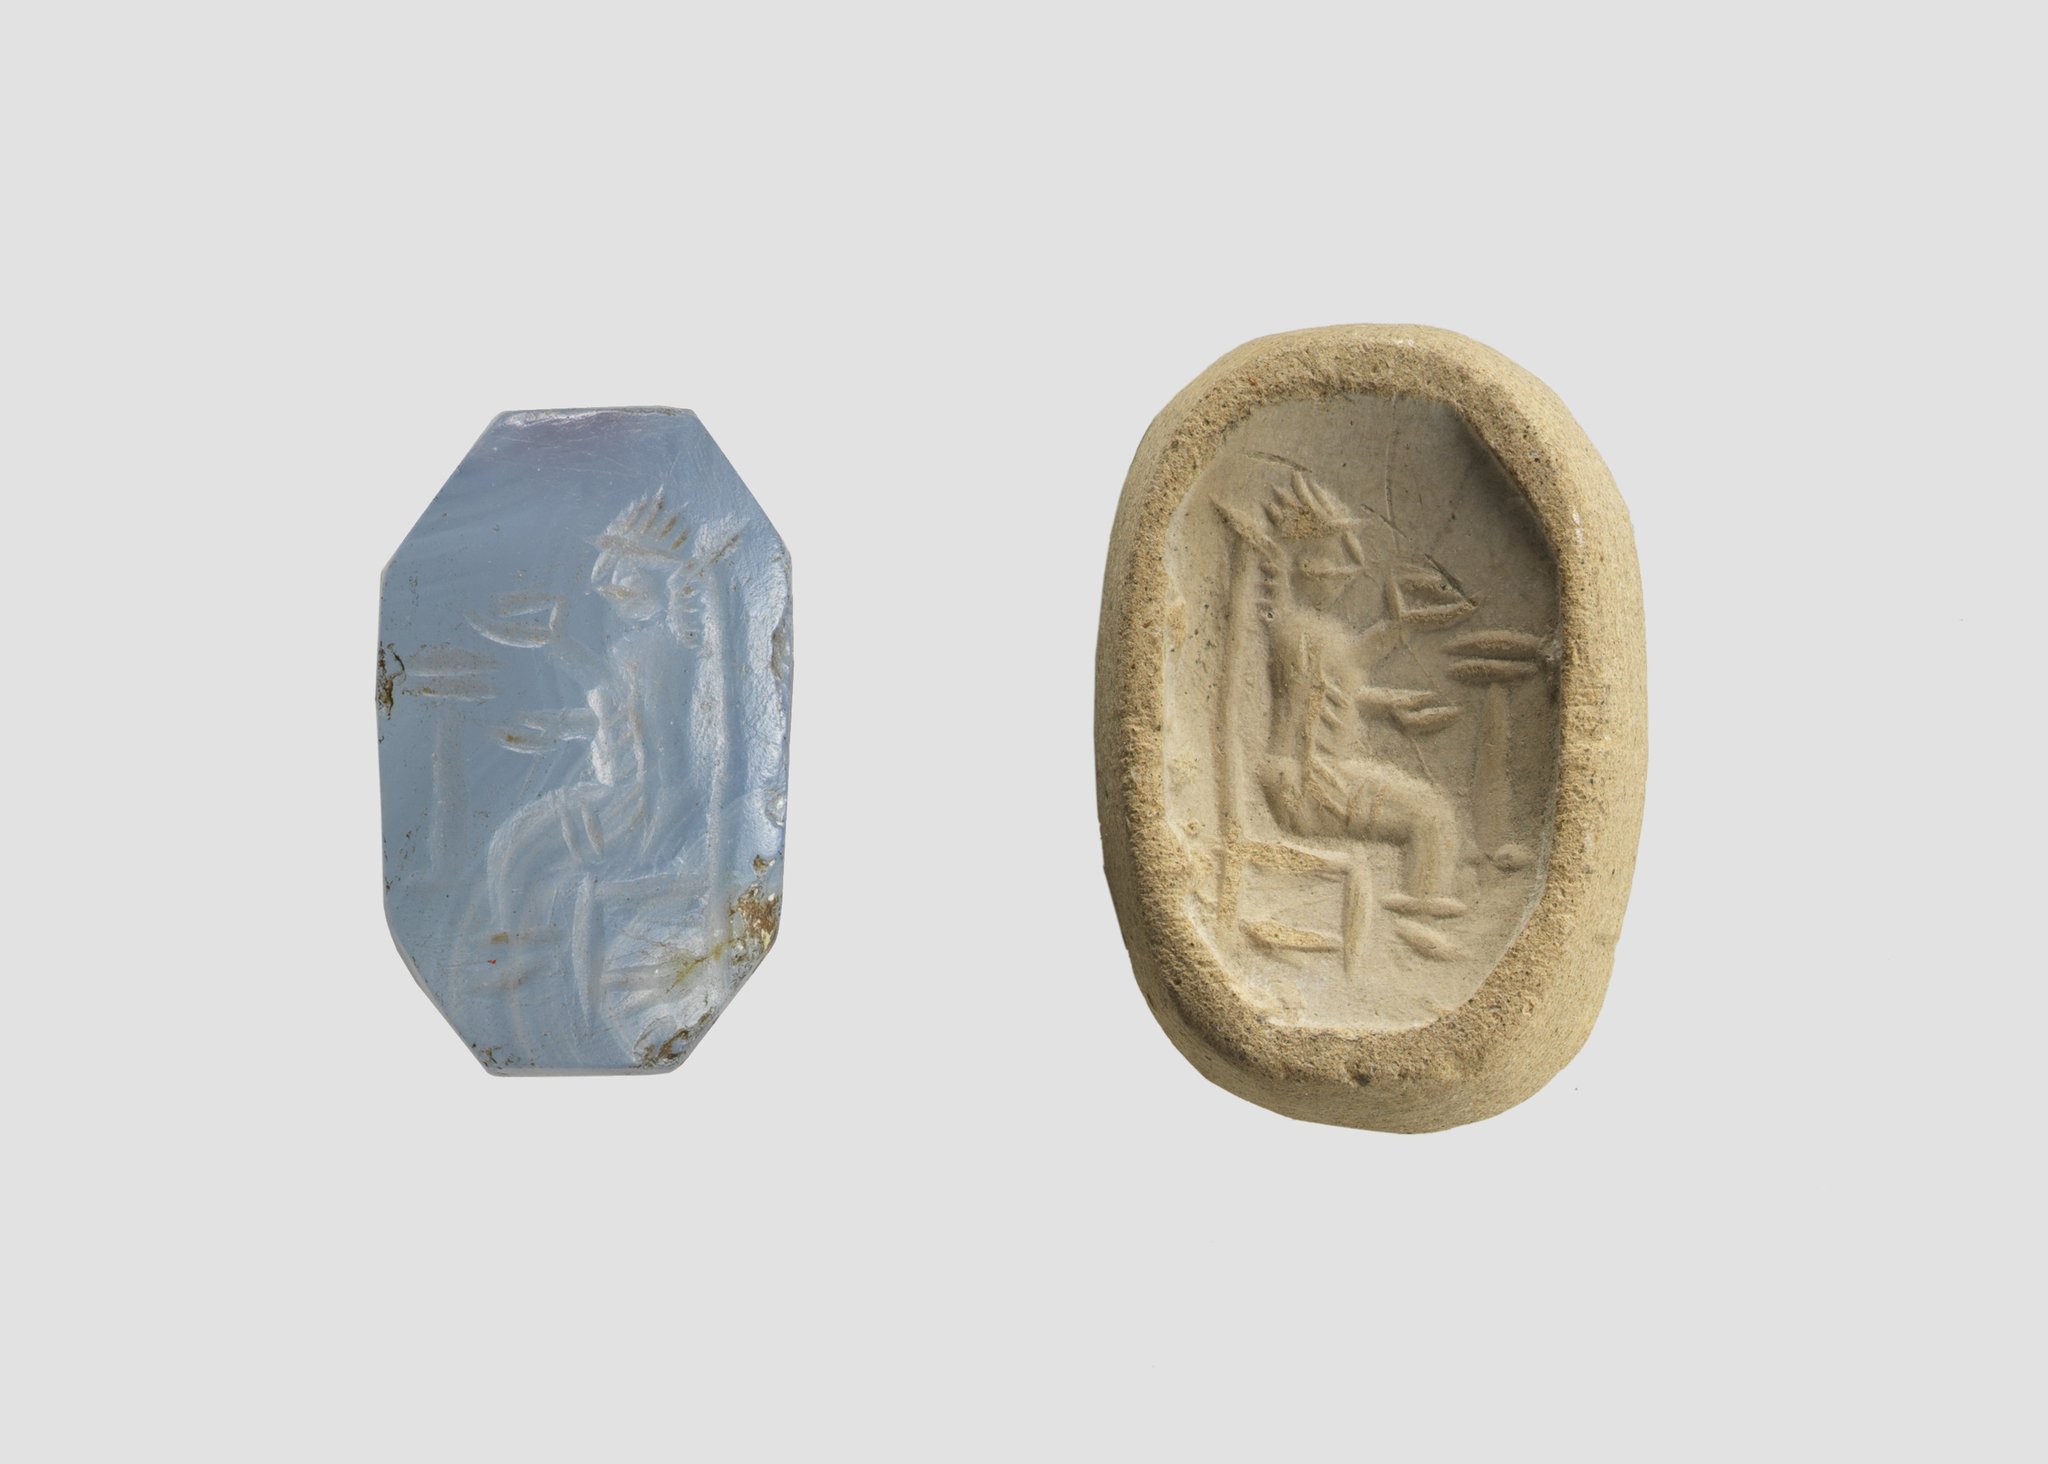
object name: stamp seal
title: Stamp seal (octagonal pyramid) with deity (?)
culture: assyro-babylonian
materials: stone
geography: iran or mesopotamia